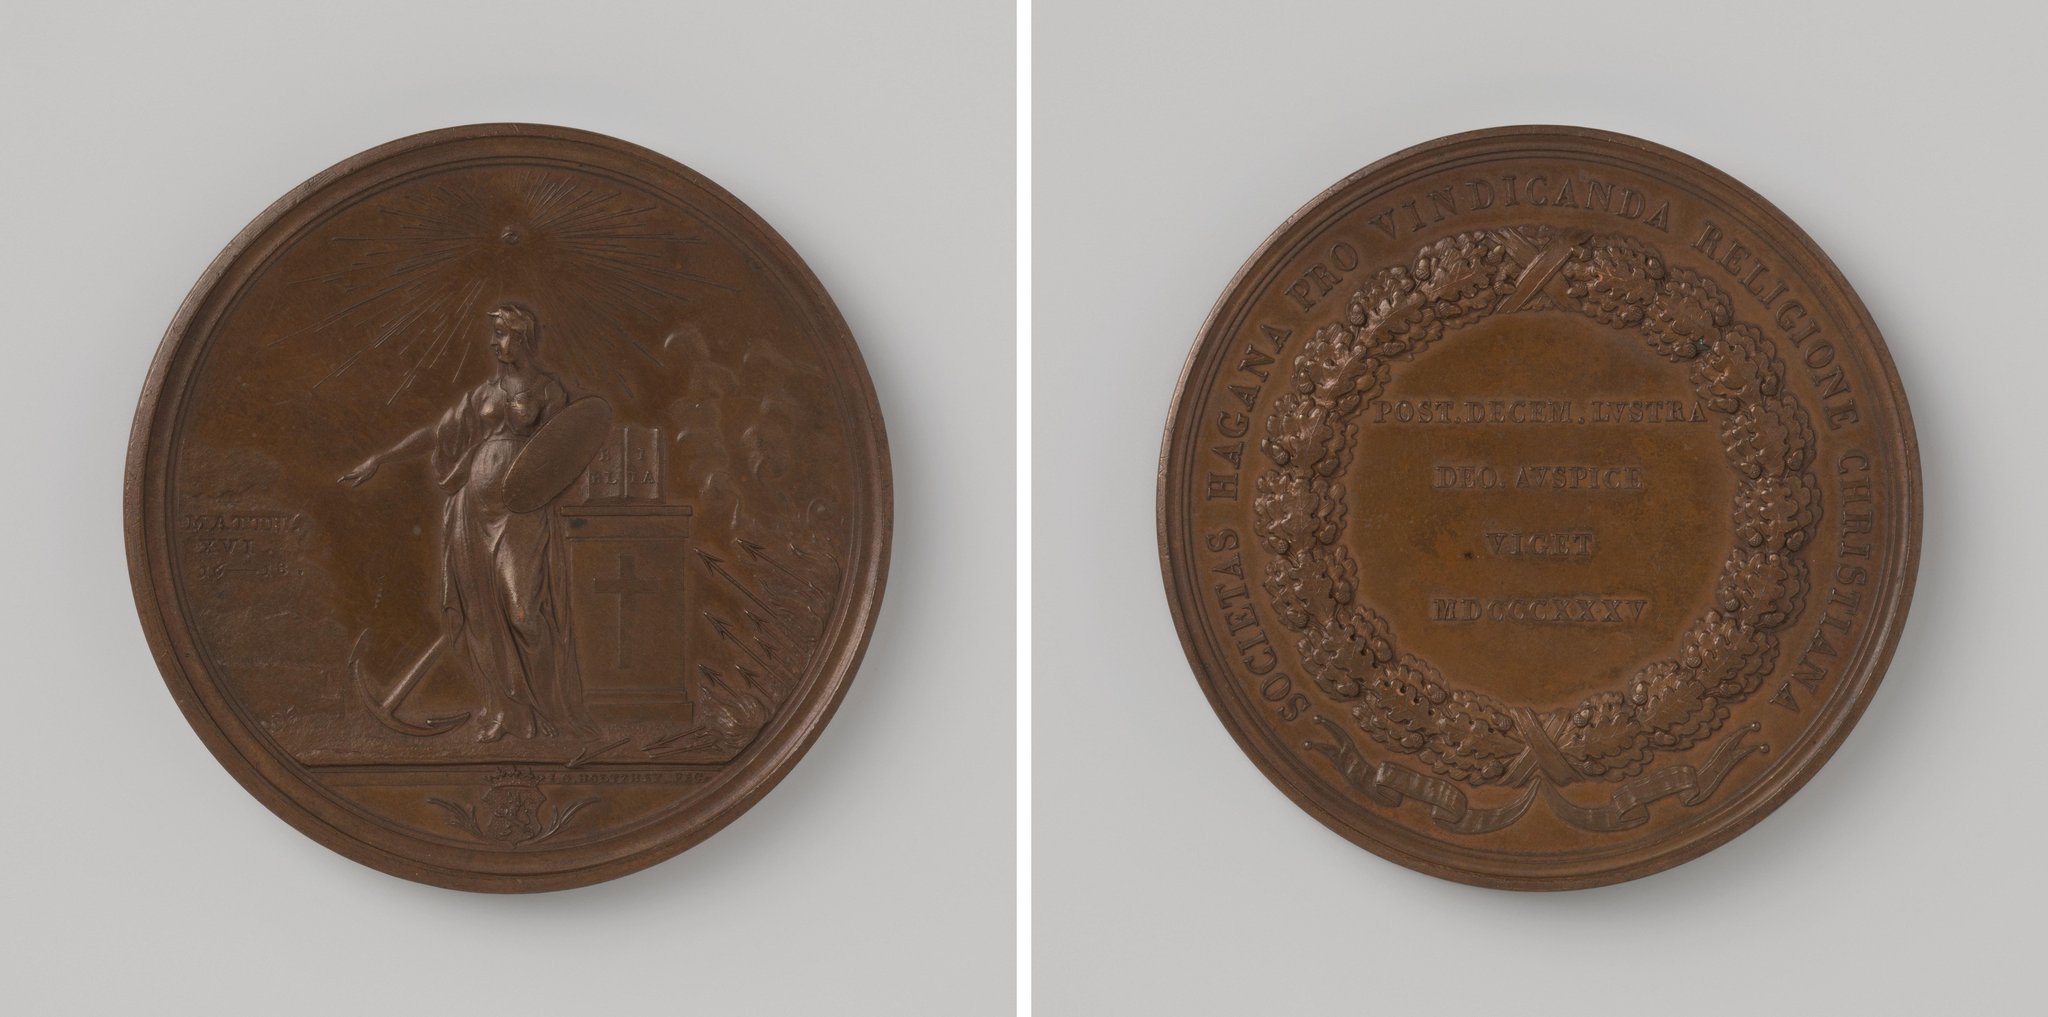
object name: history medal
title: Vijftigjarig bestaan van het Haags Genootschap tot Verdeediging van de Christelijke Godsdienst 1835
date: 1835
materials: bronze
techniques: striking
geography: amsterdam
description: Forse bronzen penning, op de voorzijde een gesluierde vrouw met schild en anker, leunend tegen een altaar met een bijbel, de linkerhand wijzend op een rots met opschrift, rechts rook en pijlen, in afsnede een klein Hollands wapenschild, op de keerzijde vier regels tekst binnen een dikke eikenkrans, met omschrift.